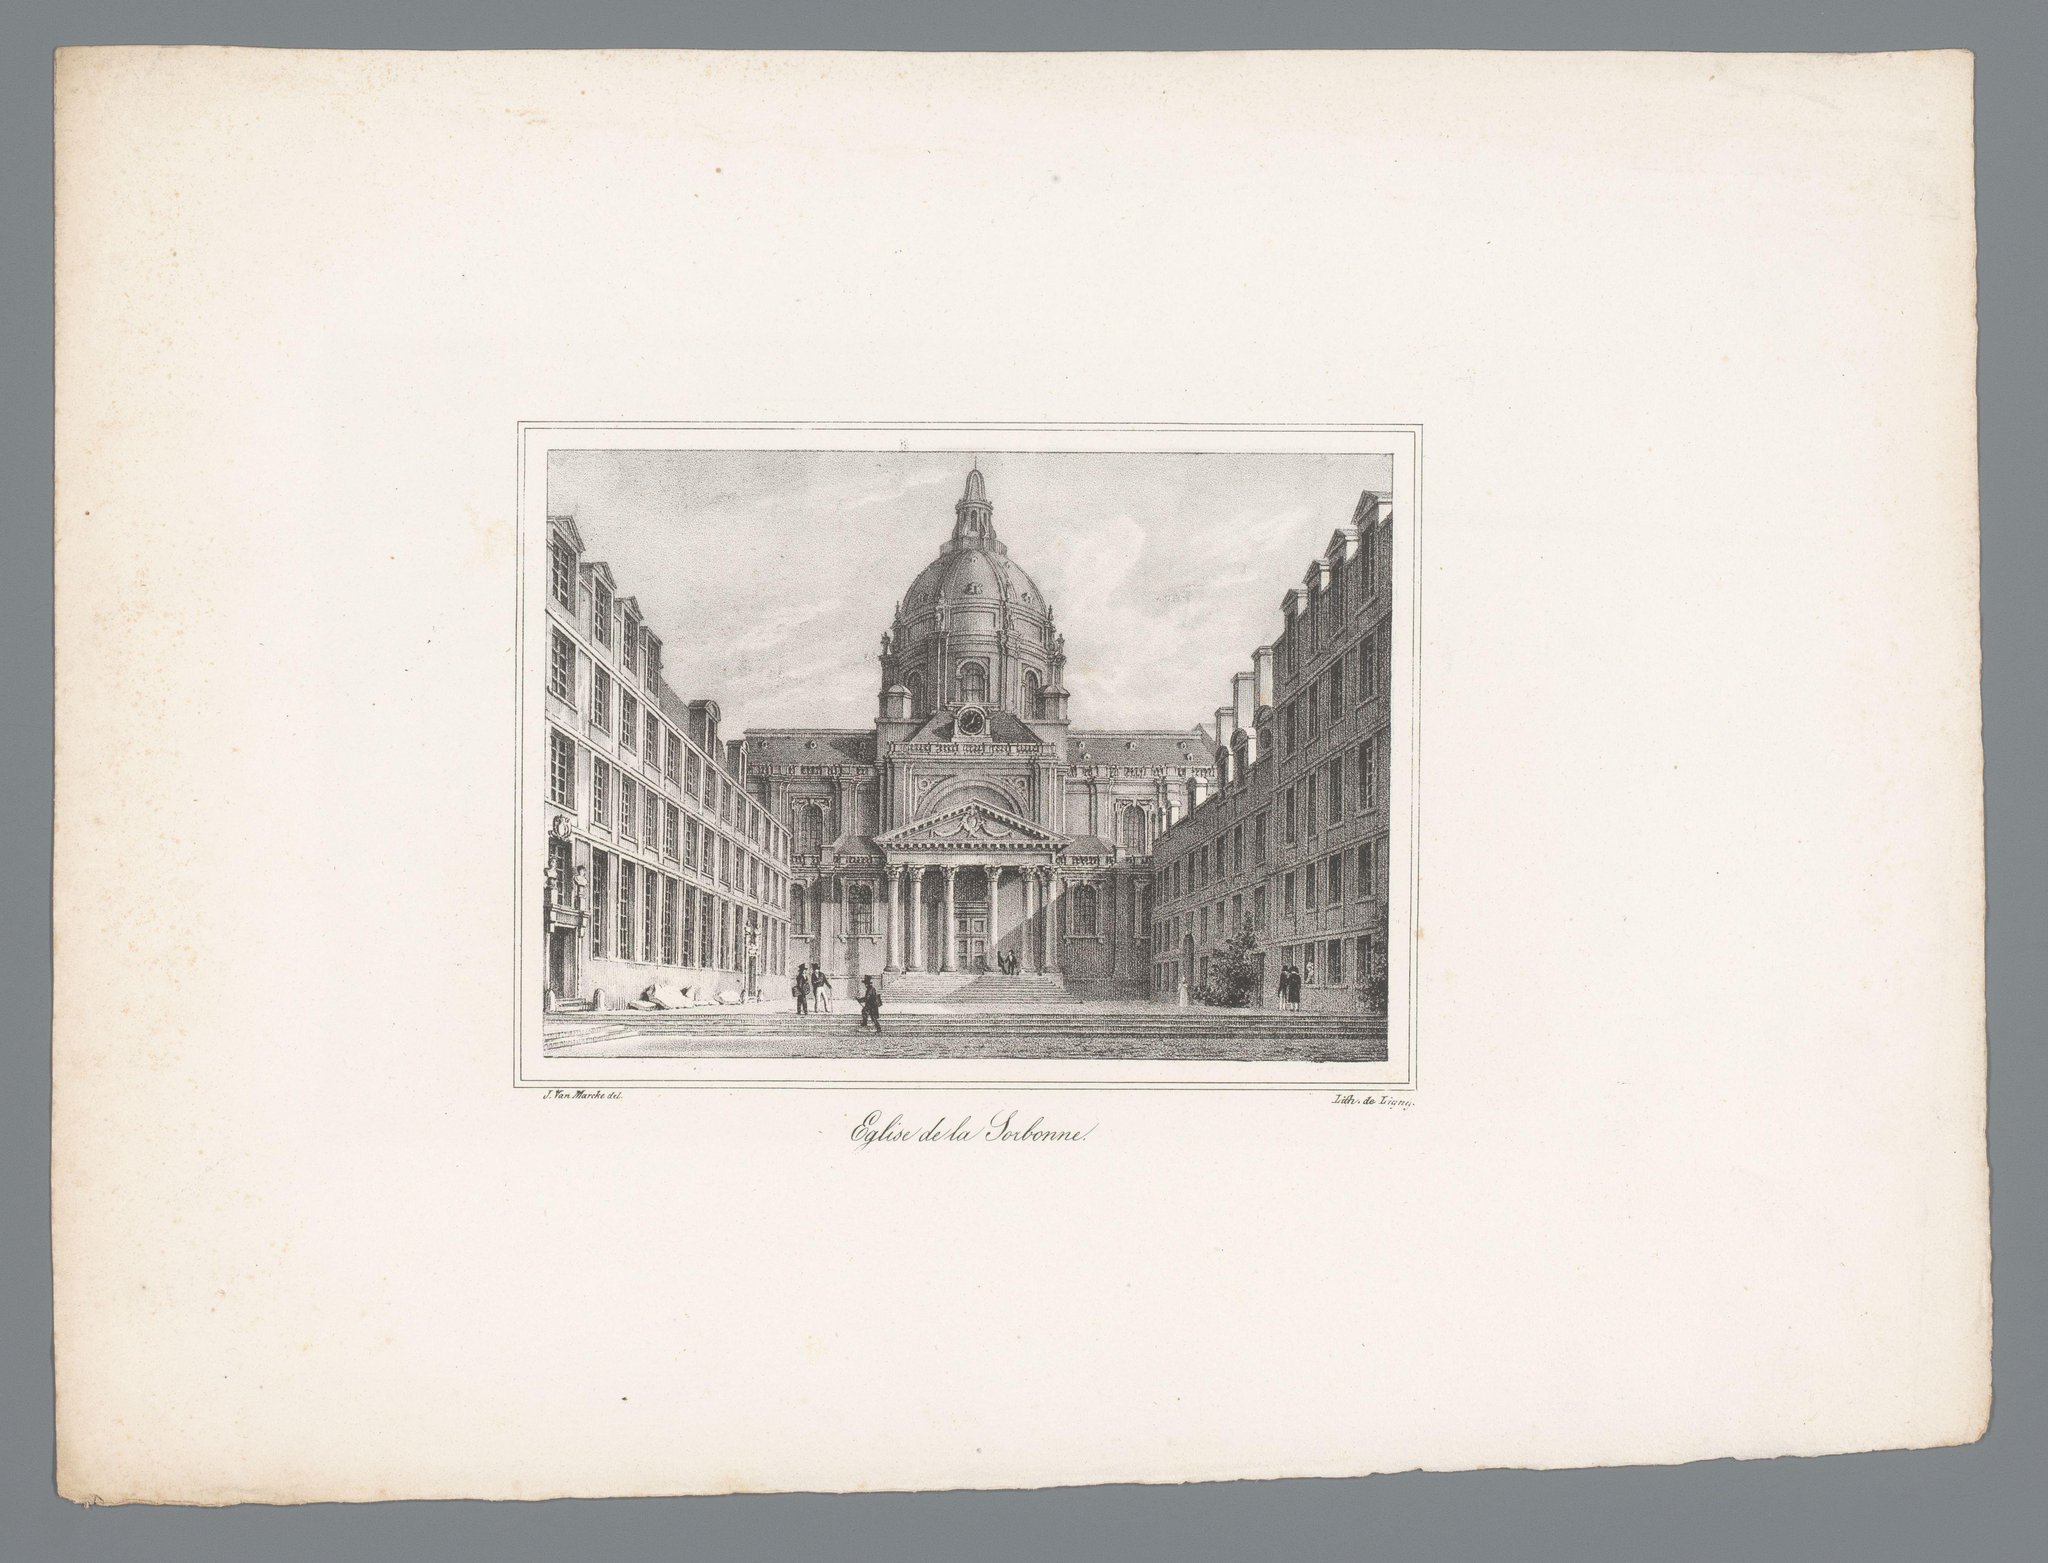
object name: print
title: Eglise de la Sorbonne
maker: de ligny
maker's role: drukkerij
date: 1808-1849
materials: paper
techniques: lithograph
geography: paris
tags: church (exterior), paris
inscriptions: collector's mark: Lugt 2228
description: In de inventaris getiteld: Vues principales de Paris. Reeks van 28 nummers. Met adres van Décrounau. Jules David, van Marke, Noël en Victor Adam. De prent is mogelijk onderdeel van een serie.